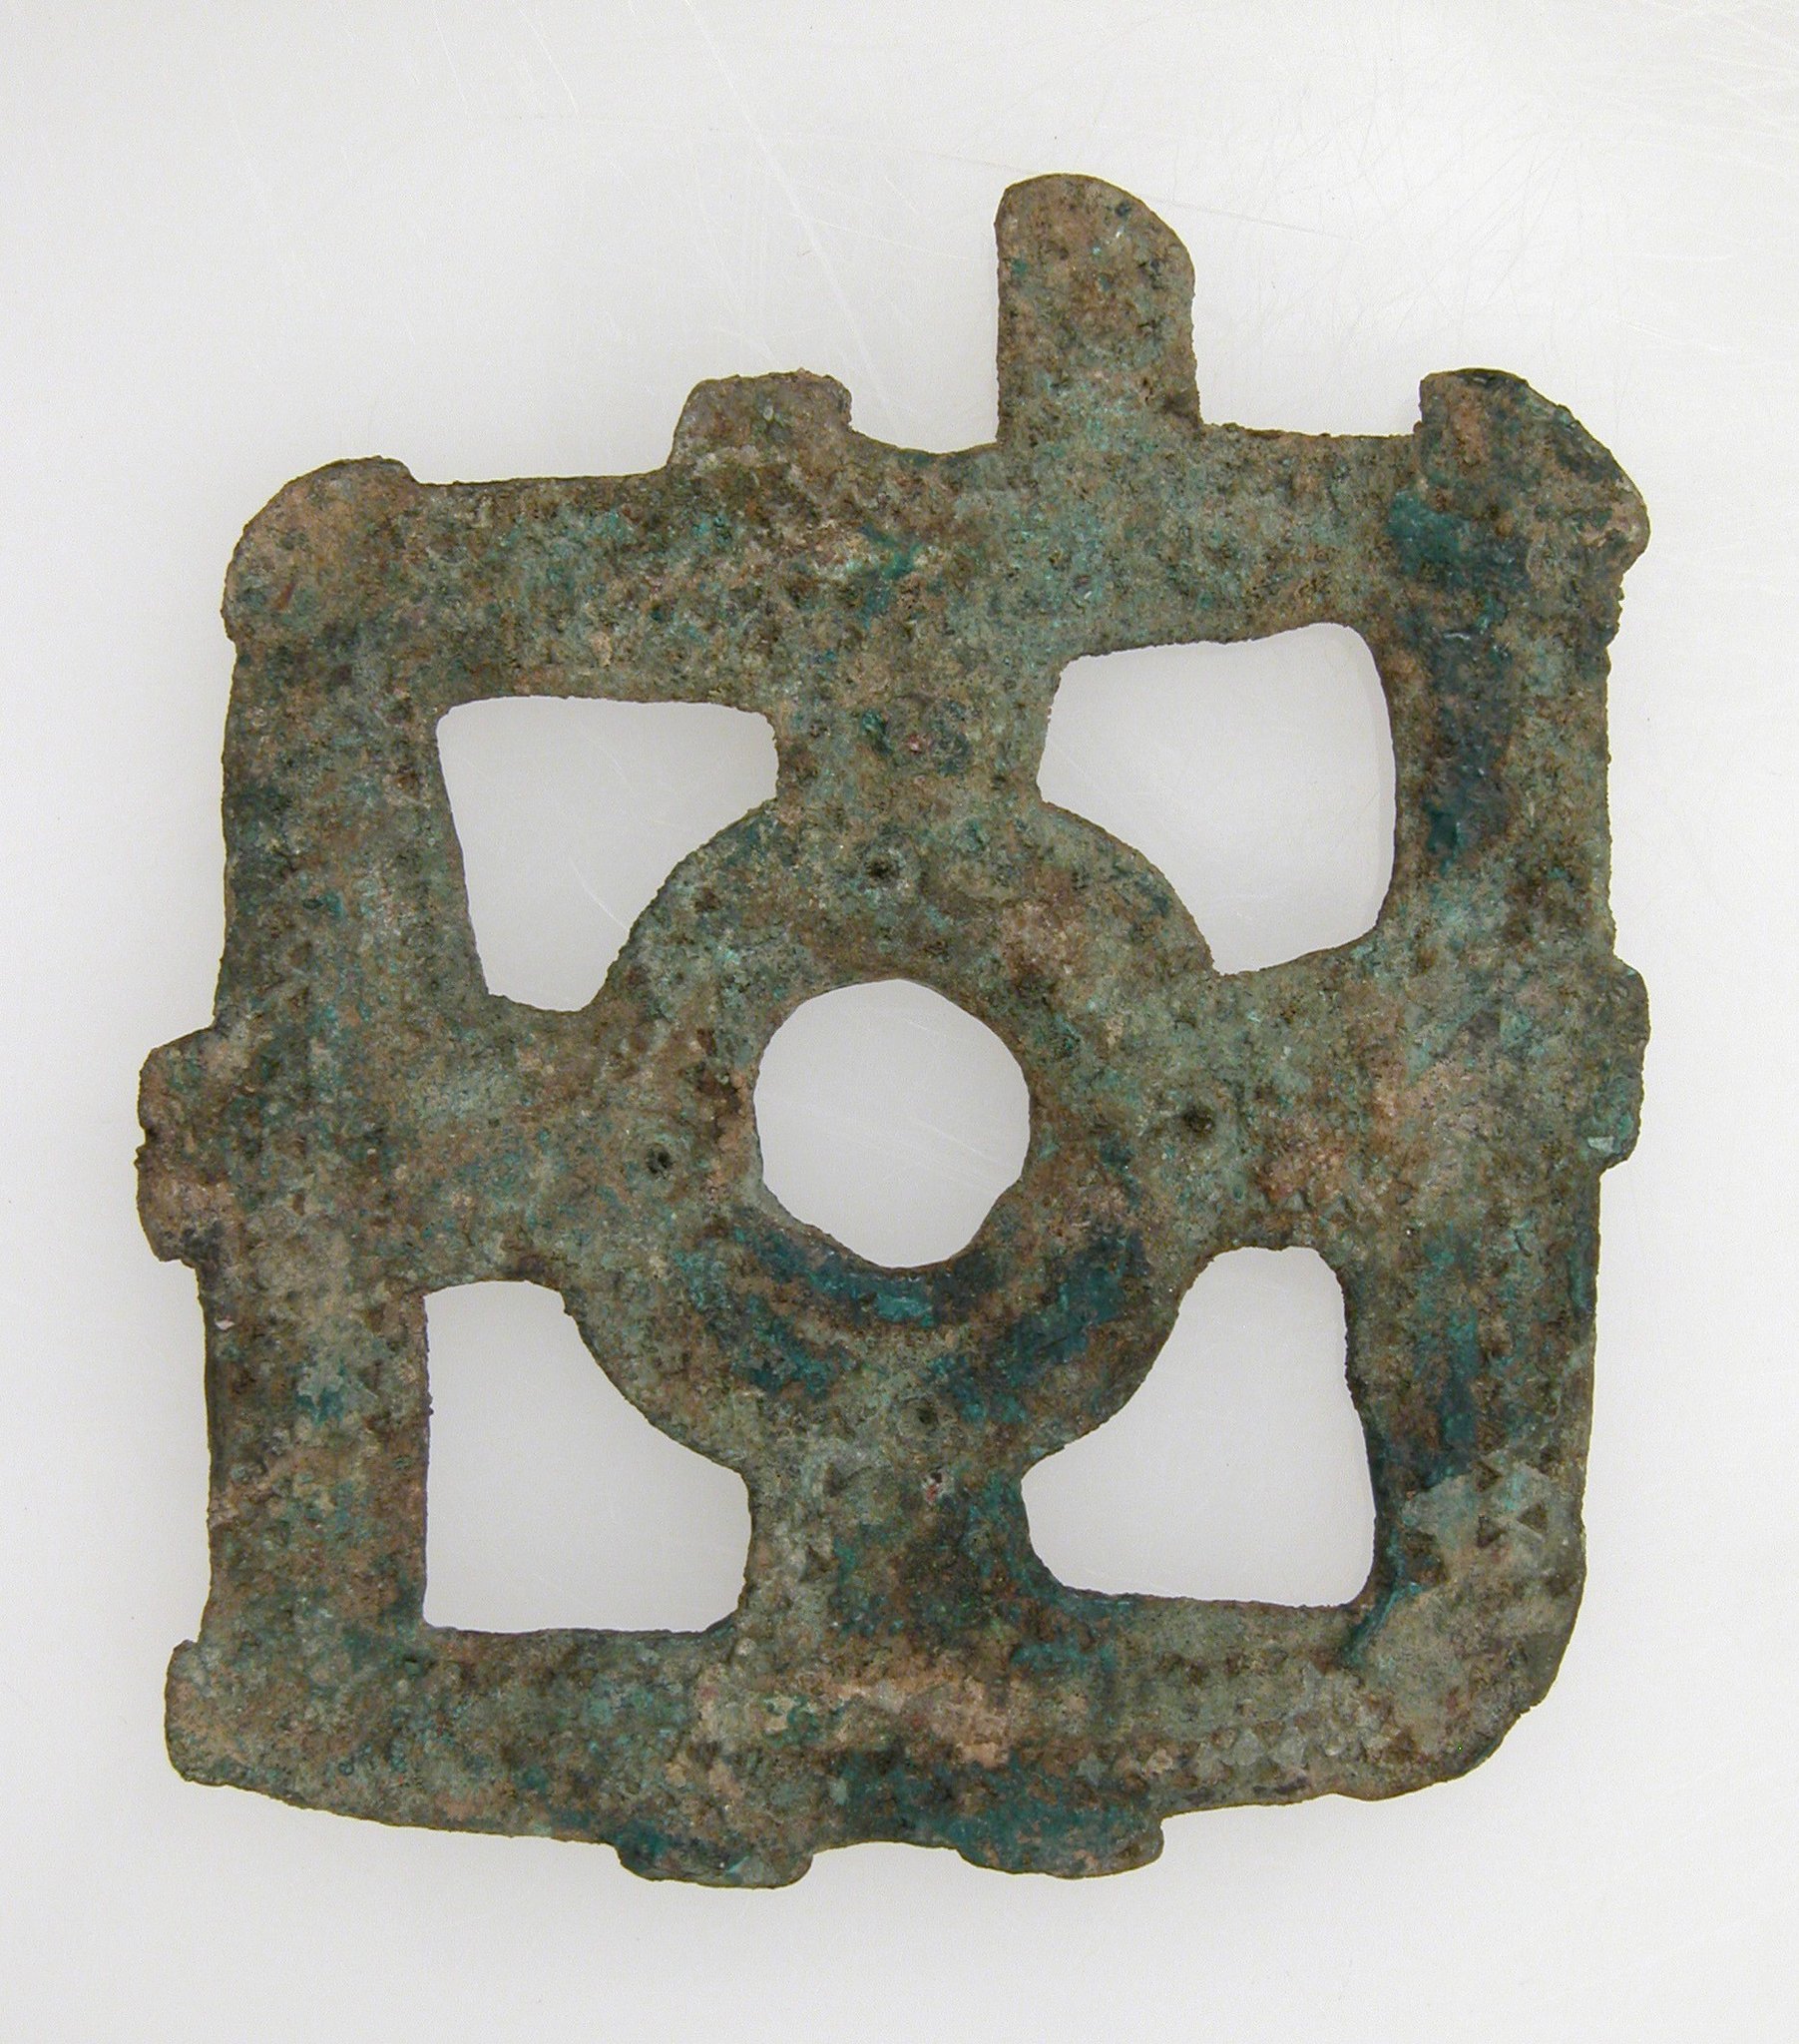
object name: plaque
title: Openwork Plaque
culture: frankish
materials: copper alloy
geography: germany